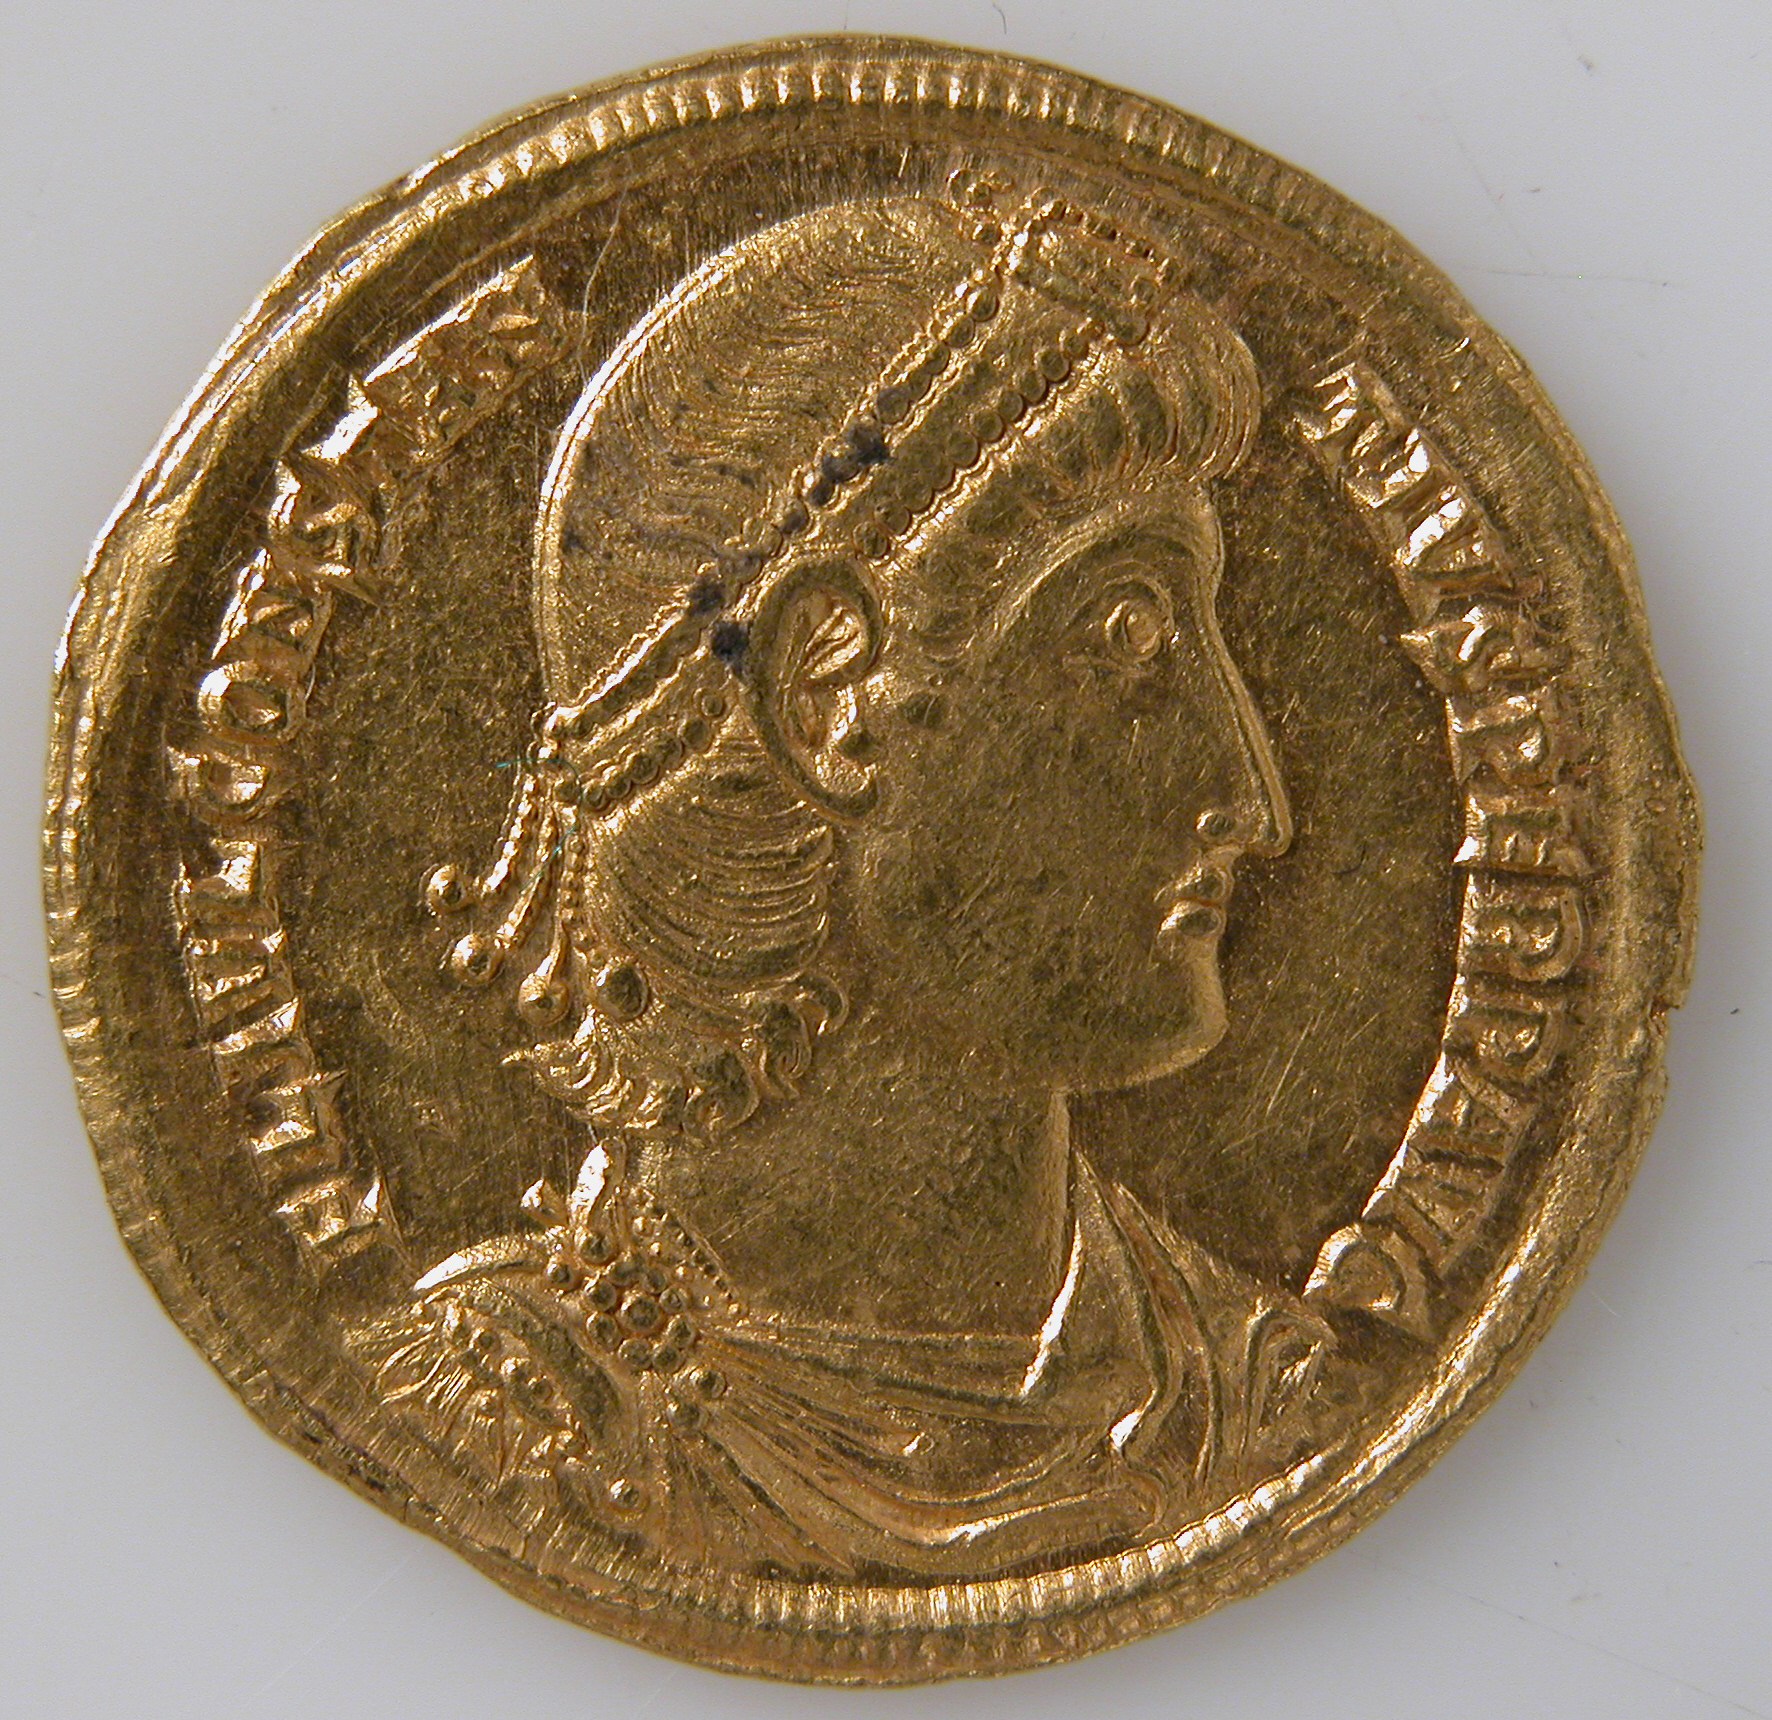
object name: solidus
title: Solidus of Constantius II (337–361)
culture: byzantine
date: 337-347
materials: gold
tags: men